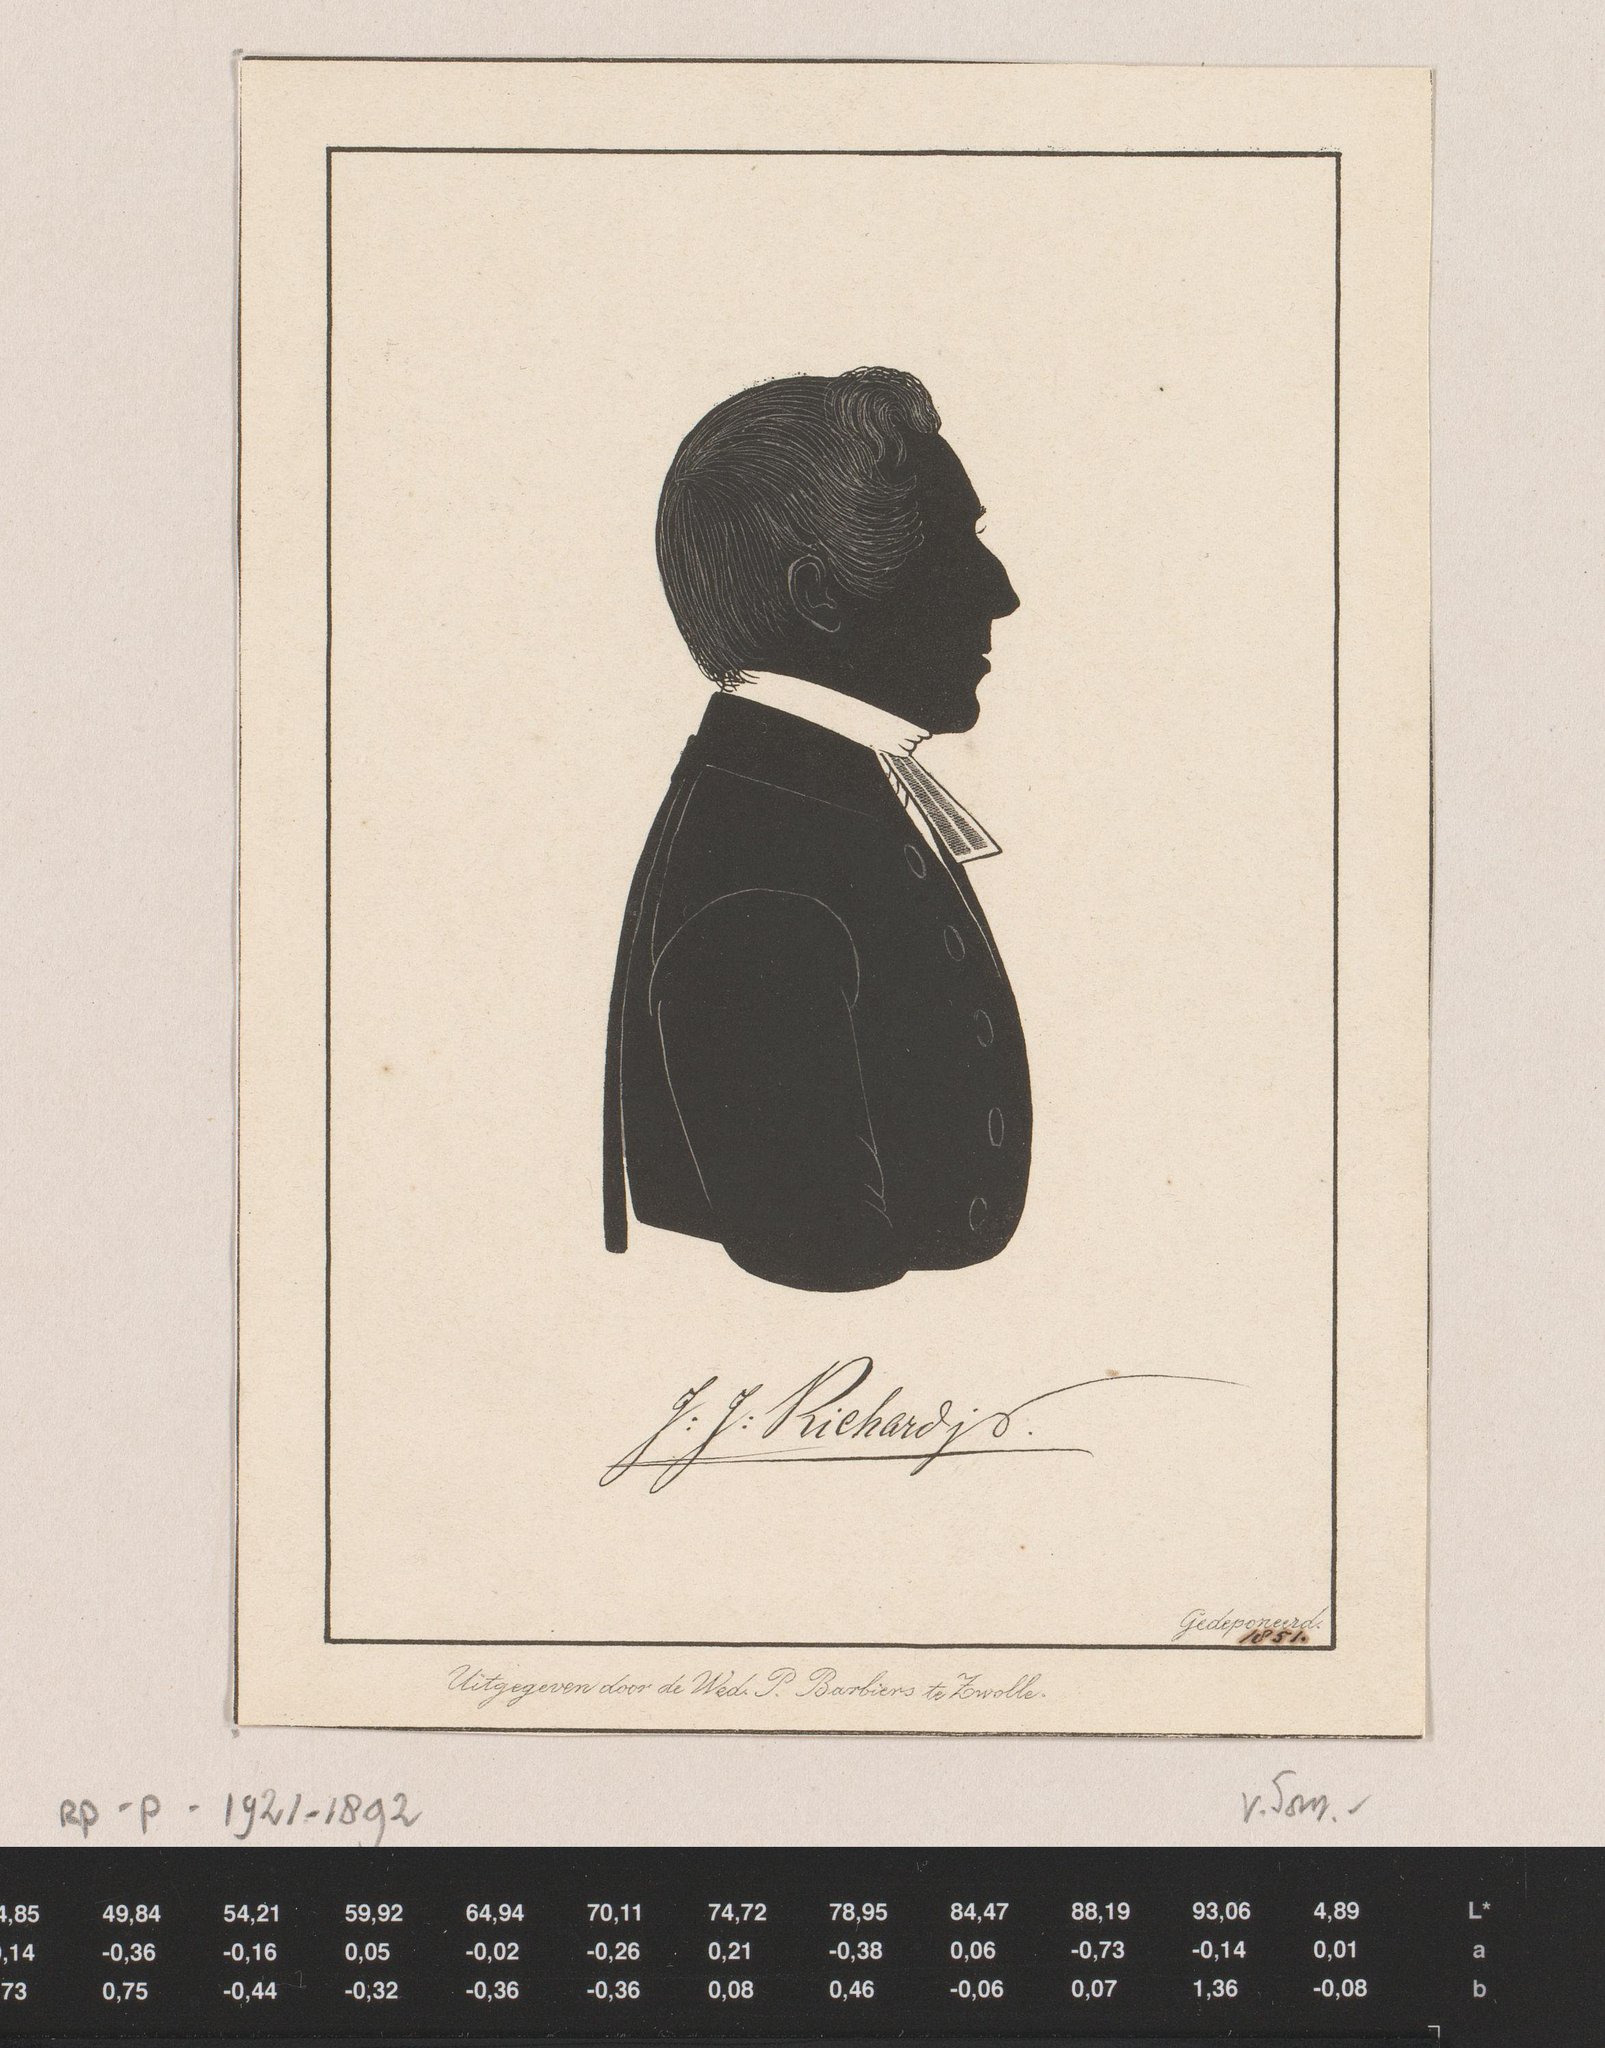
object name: print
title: Silhouetportret van Jacobus Jeremias Richard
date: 1851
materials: paper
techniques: hand coloring, lithograph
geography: zwolle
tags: amsterdam, historical persons, functionaries and dignitaries ~ protestant churches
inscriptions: collector's mark: Lugt 2233, : ‘Gedeponeerd. / 1851.’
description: Met facsimile handtekening van de geportretteerde.